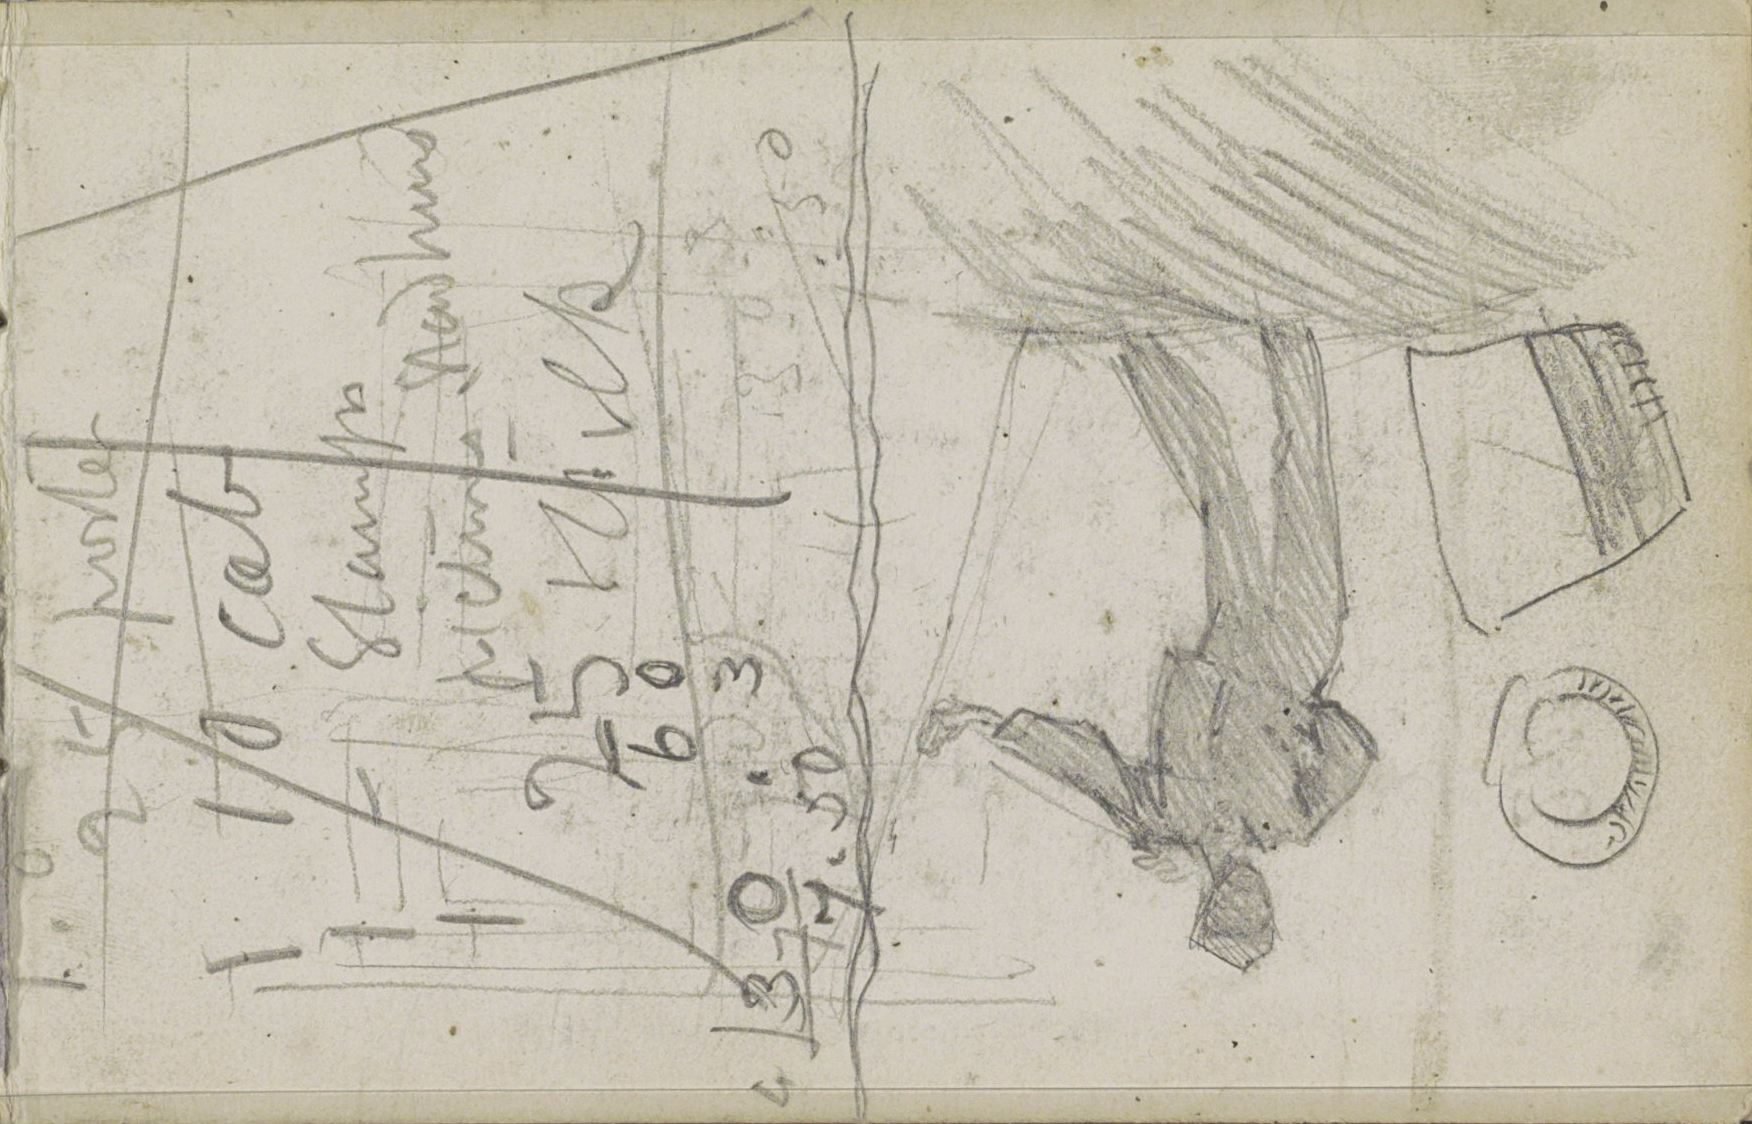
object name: sketchbook leaf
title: Staande man met een stok in de hand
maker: george clausen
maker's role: draughtsman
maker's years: 1852-1912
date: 1875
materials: paper, pencil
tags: standing figure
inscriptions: annotation: ‘[...]’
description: Tevens studies van twee voorwerpen. Blad 1 recto uit een schetsboek met 38 bladen.